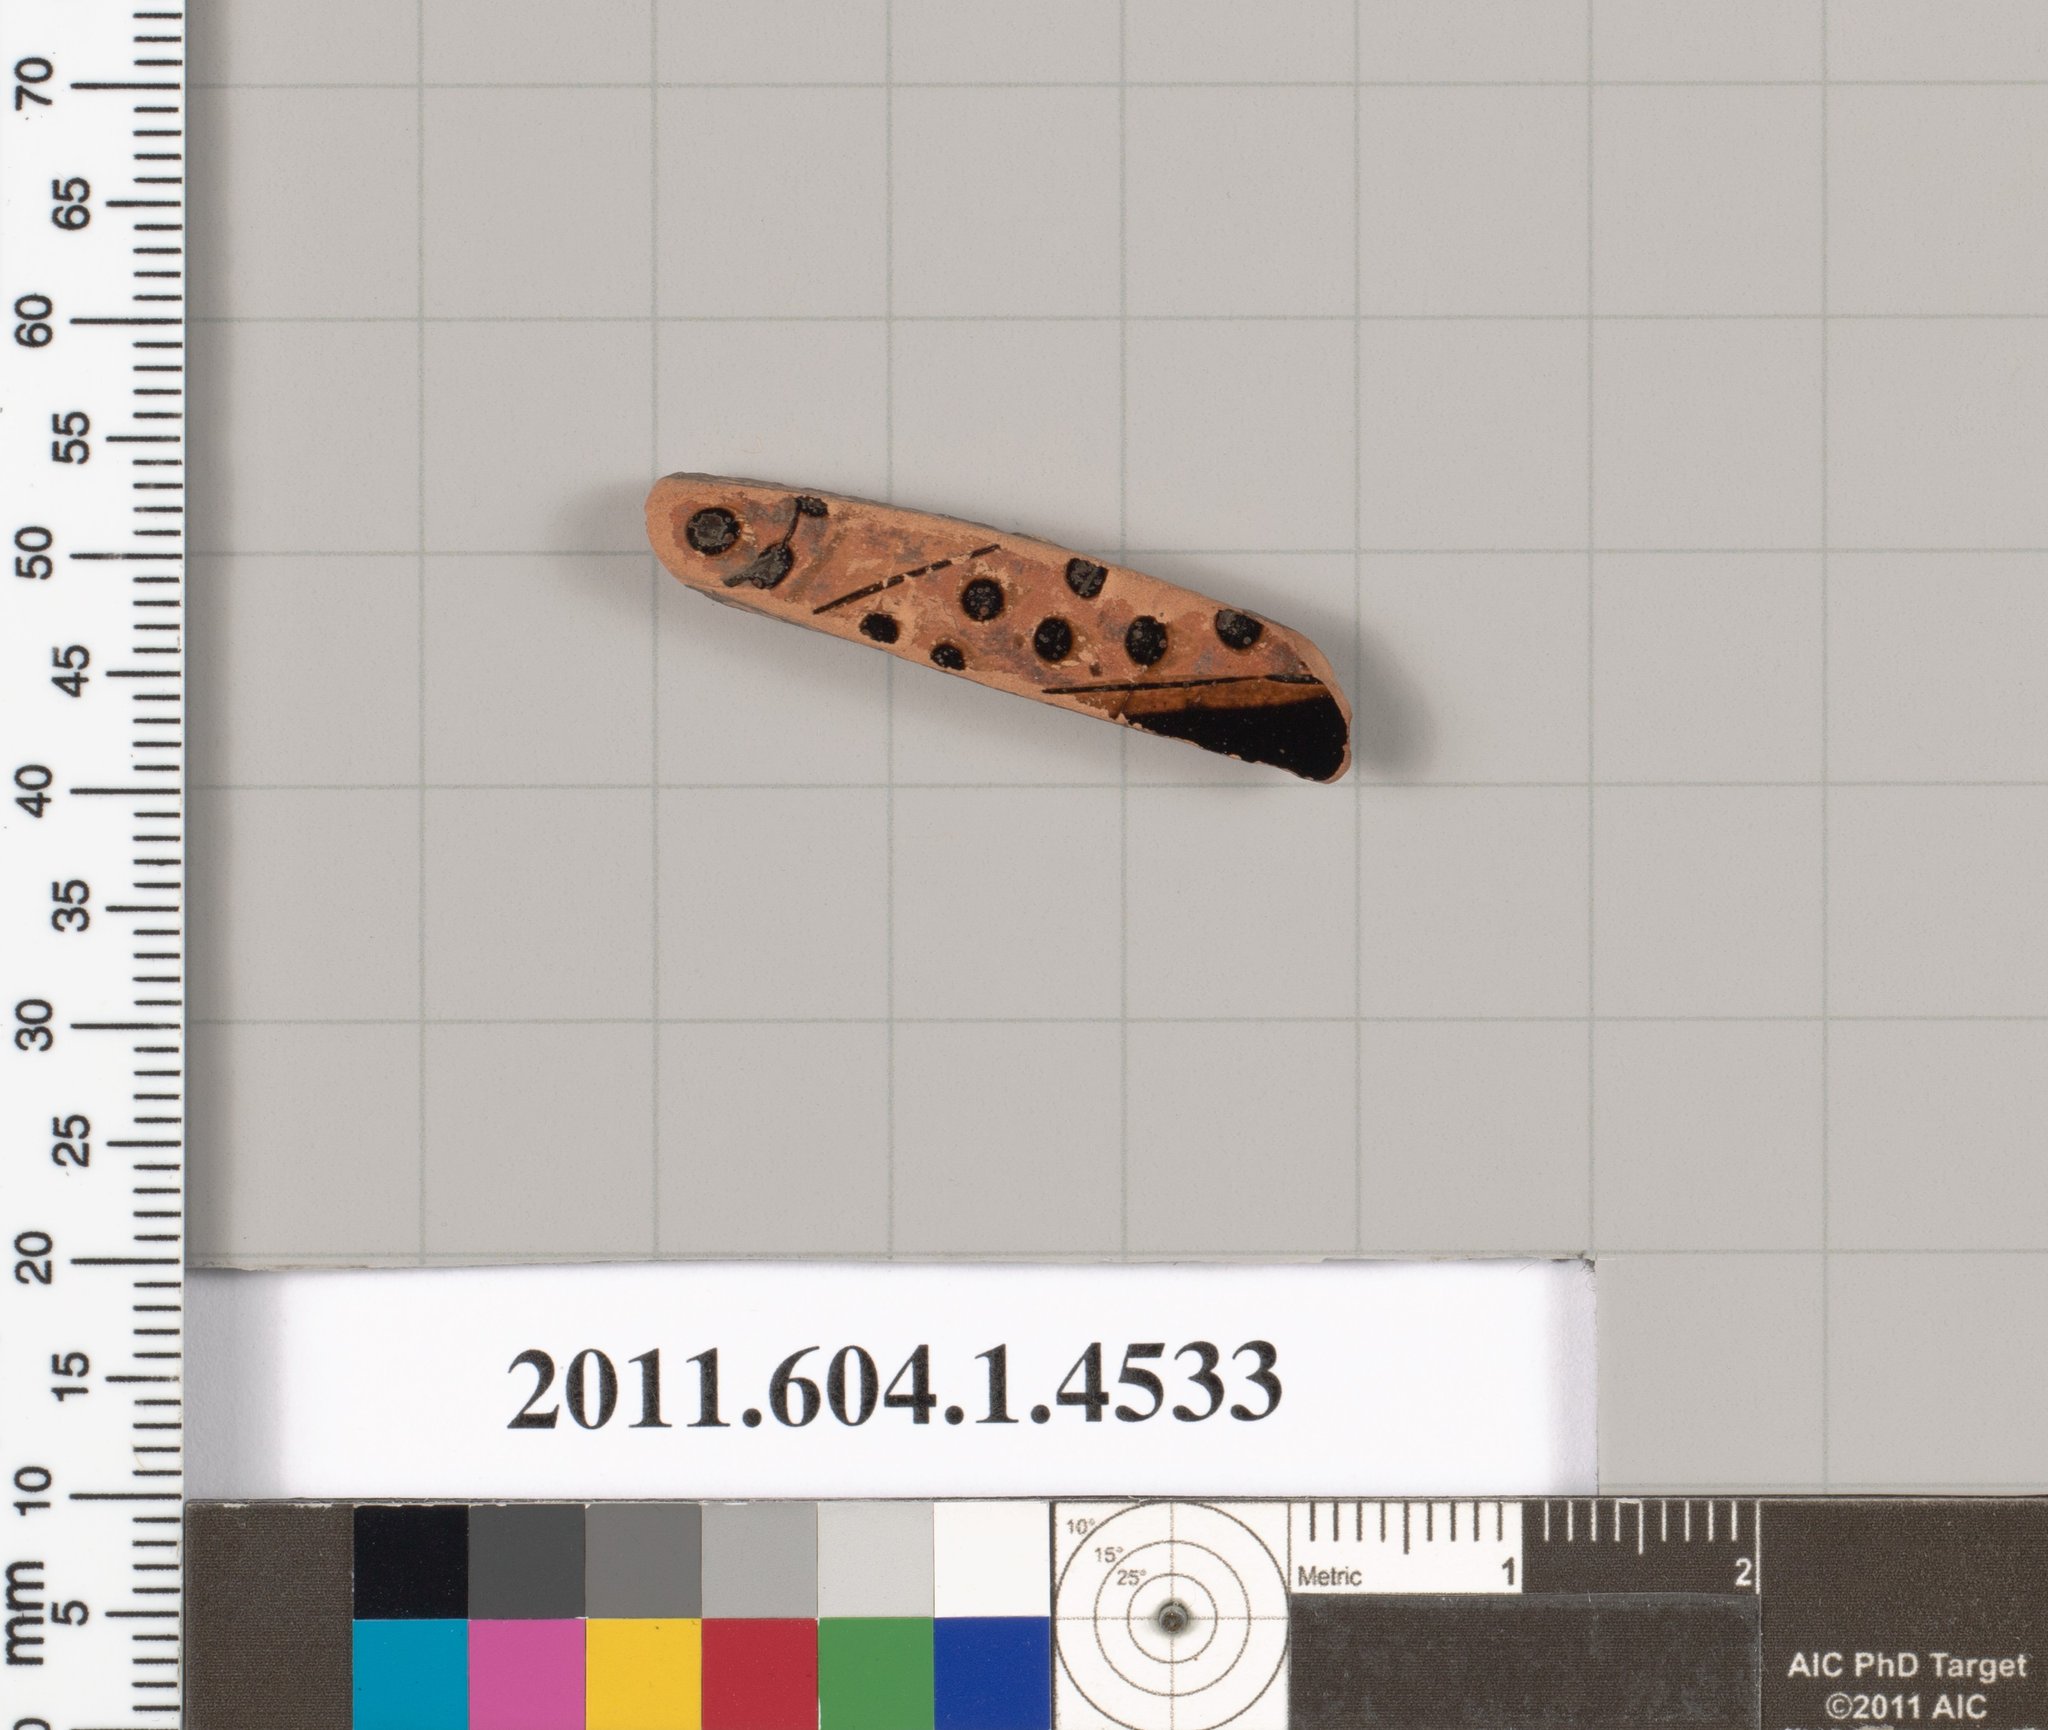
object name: kylix fragment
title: Terracotta fragment of a kylix (drinking cup)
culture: greek, attic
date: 500-480 BCE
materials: terracotta